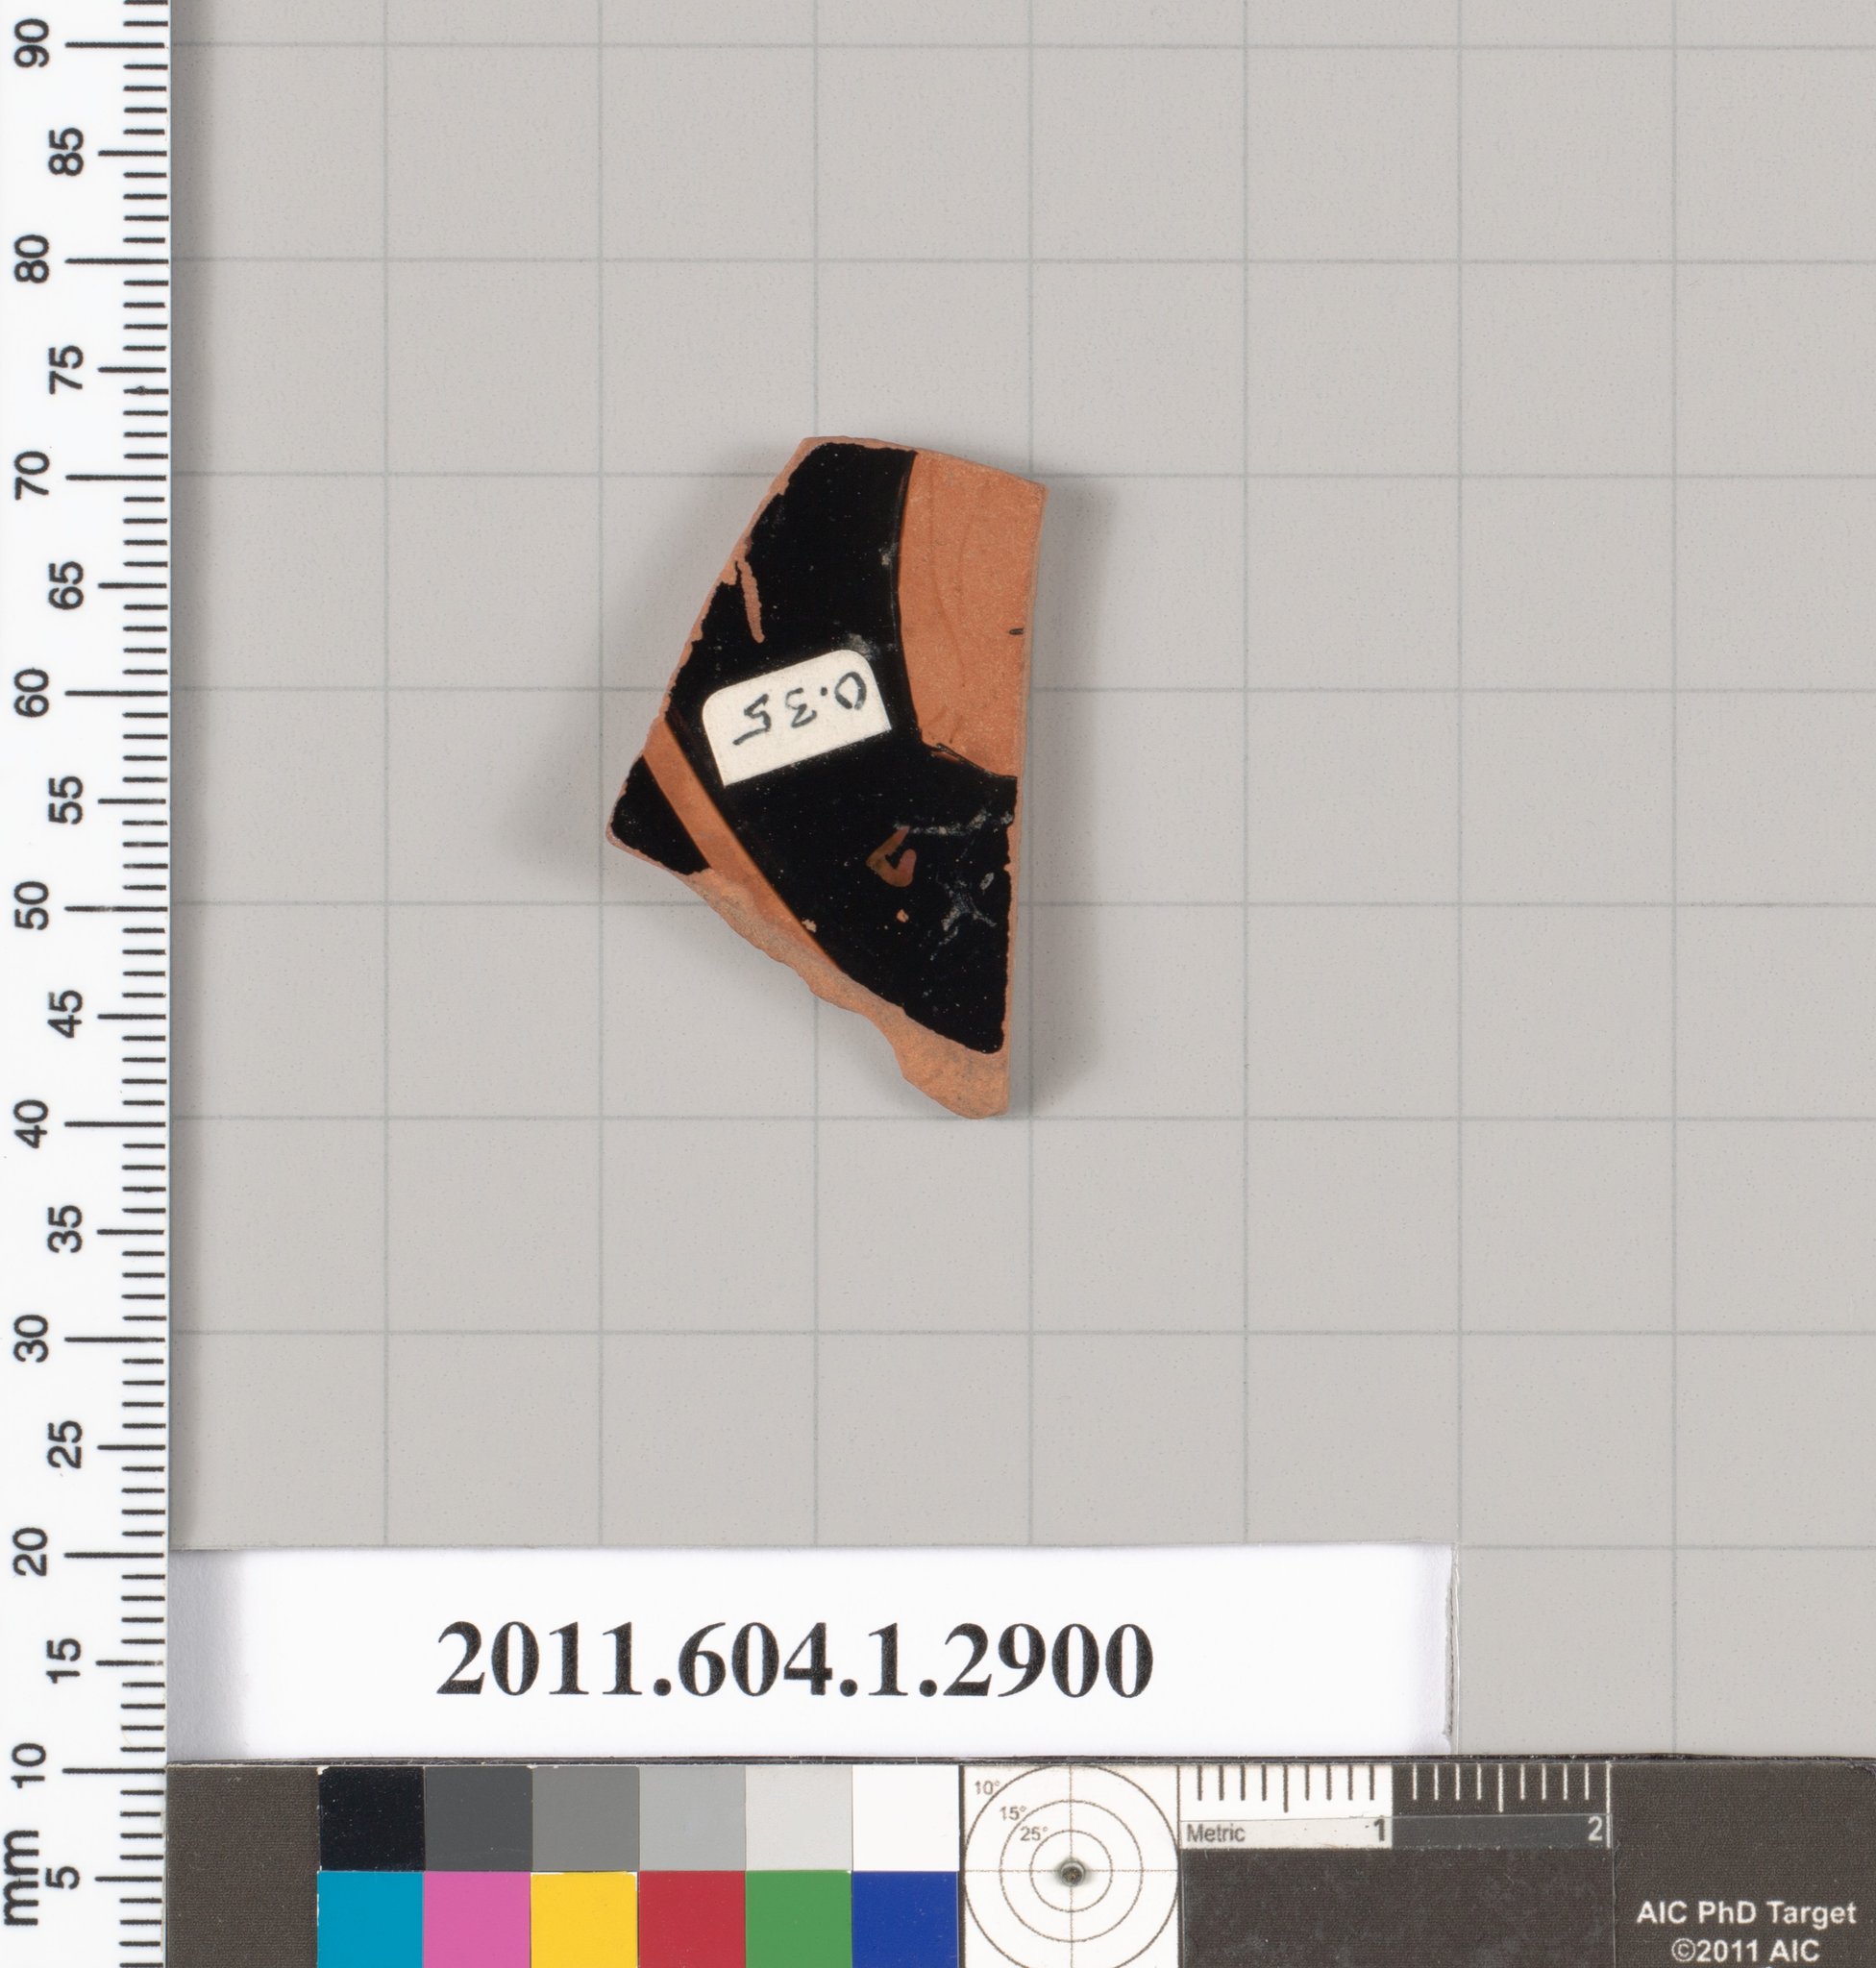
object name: kylix fragment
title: Terracotta fragment of a kylix (drinking cup)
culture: greek, attic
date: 520-500 BCE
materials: terracotta